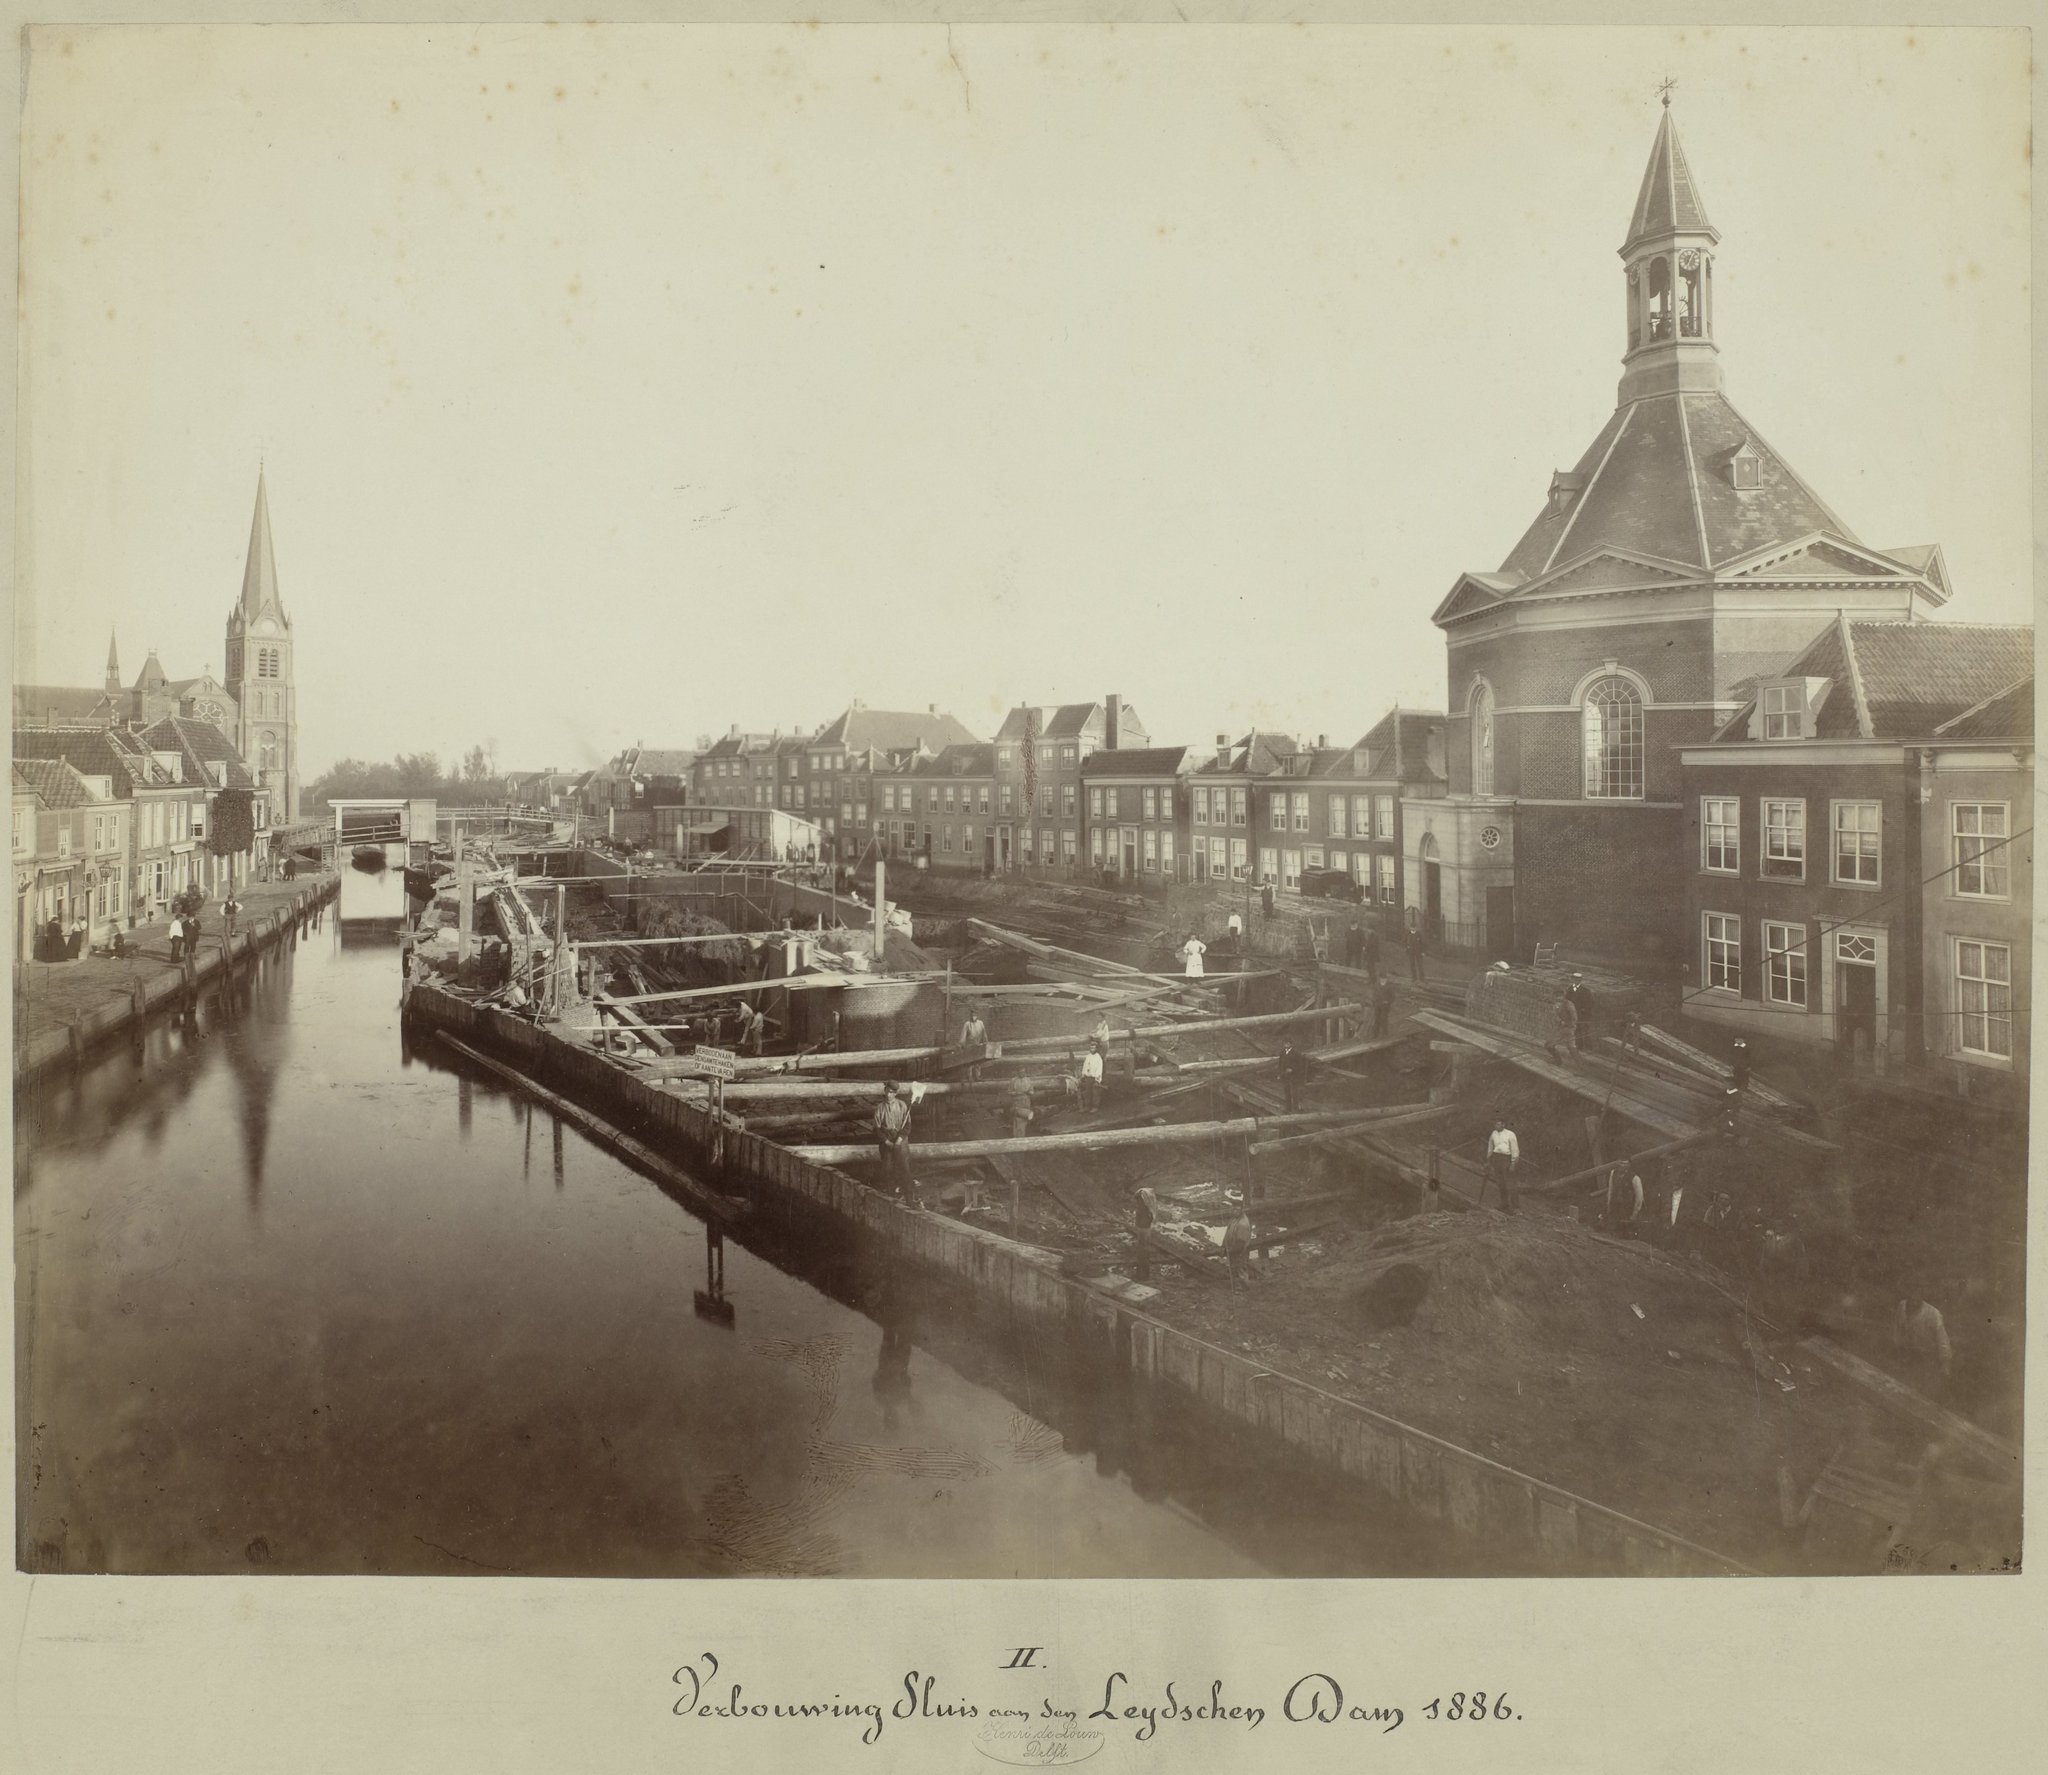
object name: photograph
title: Verbouwing Sluis aan den Leydschen Dam 1886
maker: henri de louw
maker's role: fotograaf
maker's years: 1851-1944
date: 1886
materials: cardboard, paper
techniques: photography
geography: delft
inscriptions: date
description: Foto op karton van de verbouwing van een sluis. Gesigneerd en gedateerd.